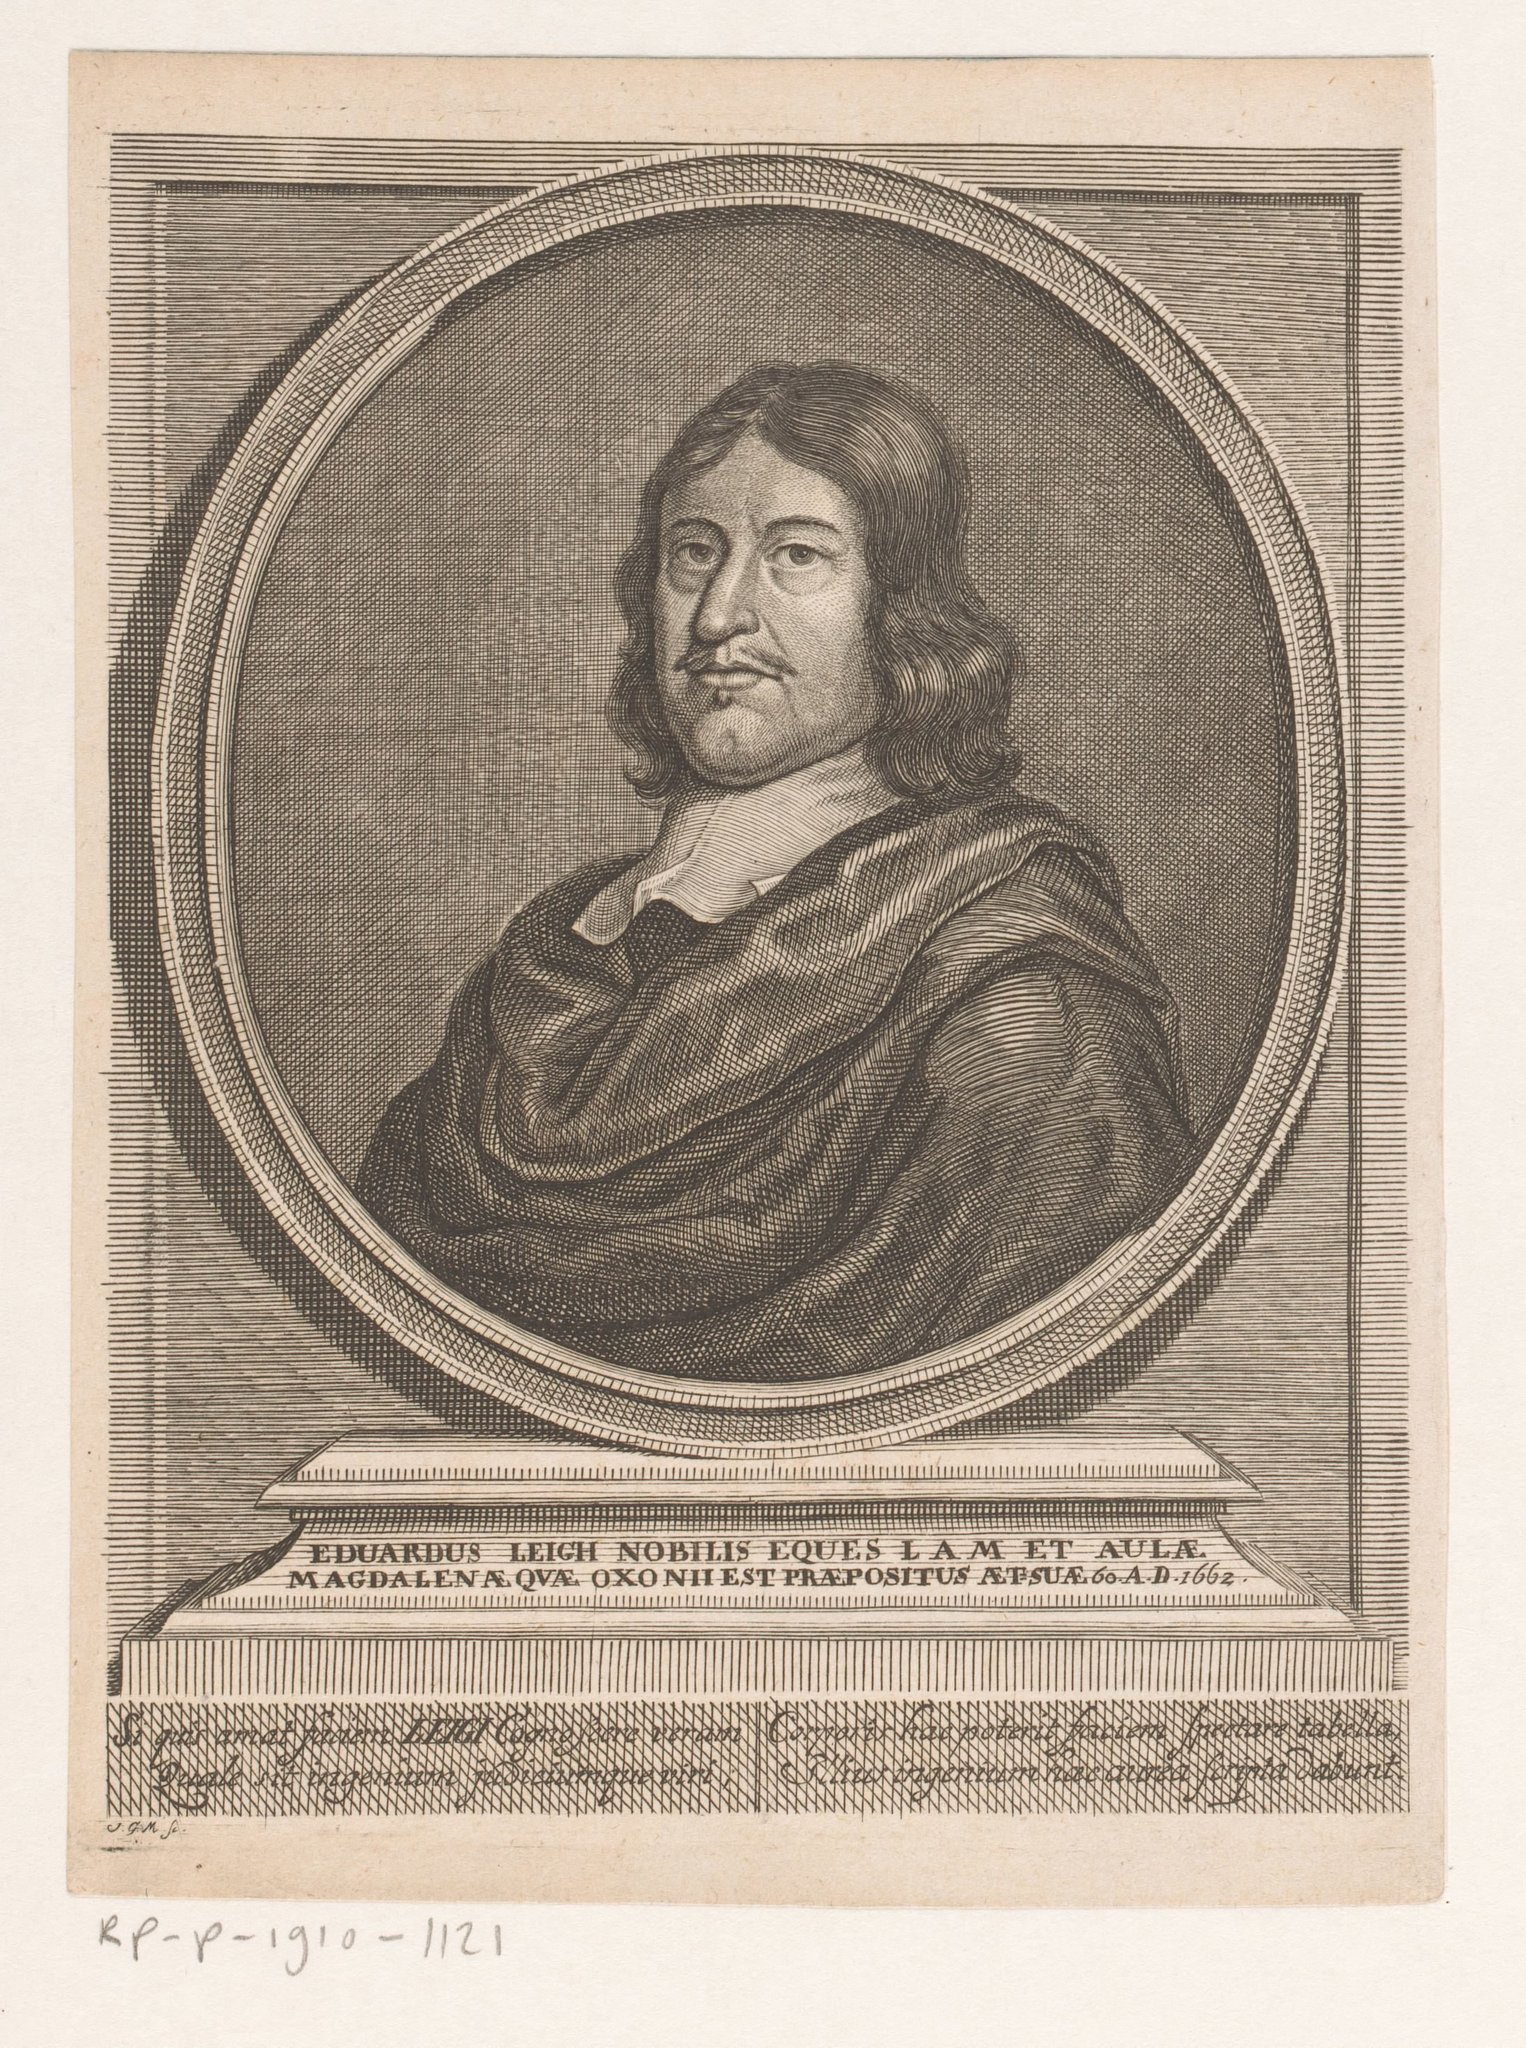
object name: print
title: Portret van Edward Leigh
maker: johann georg mentzel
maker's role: print maker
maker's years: 1677-1743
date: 1687-1743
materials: paper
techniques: engraving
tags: historical persons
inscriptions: collector's mark: Lugt 2228